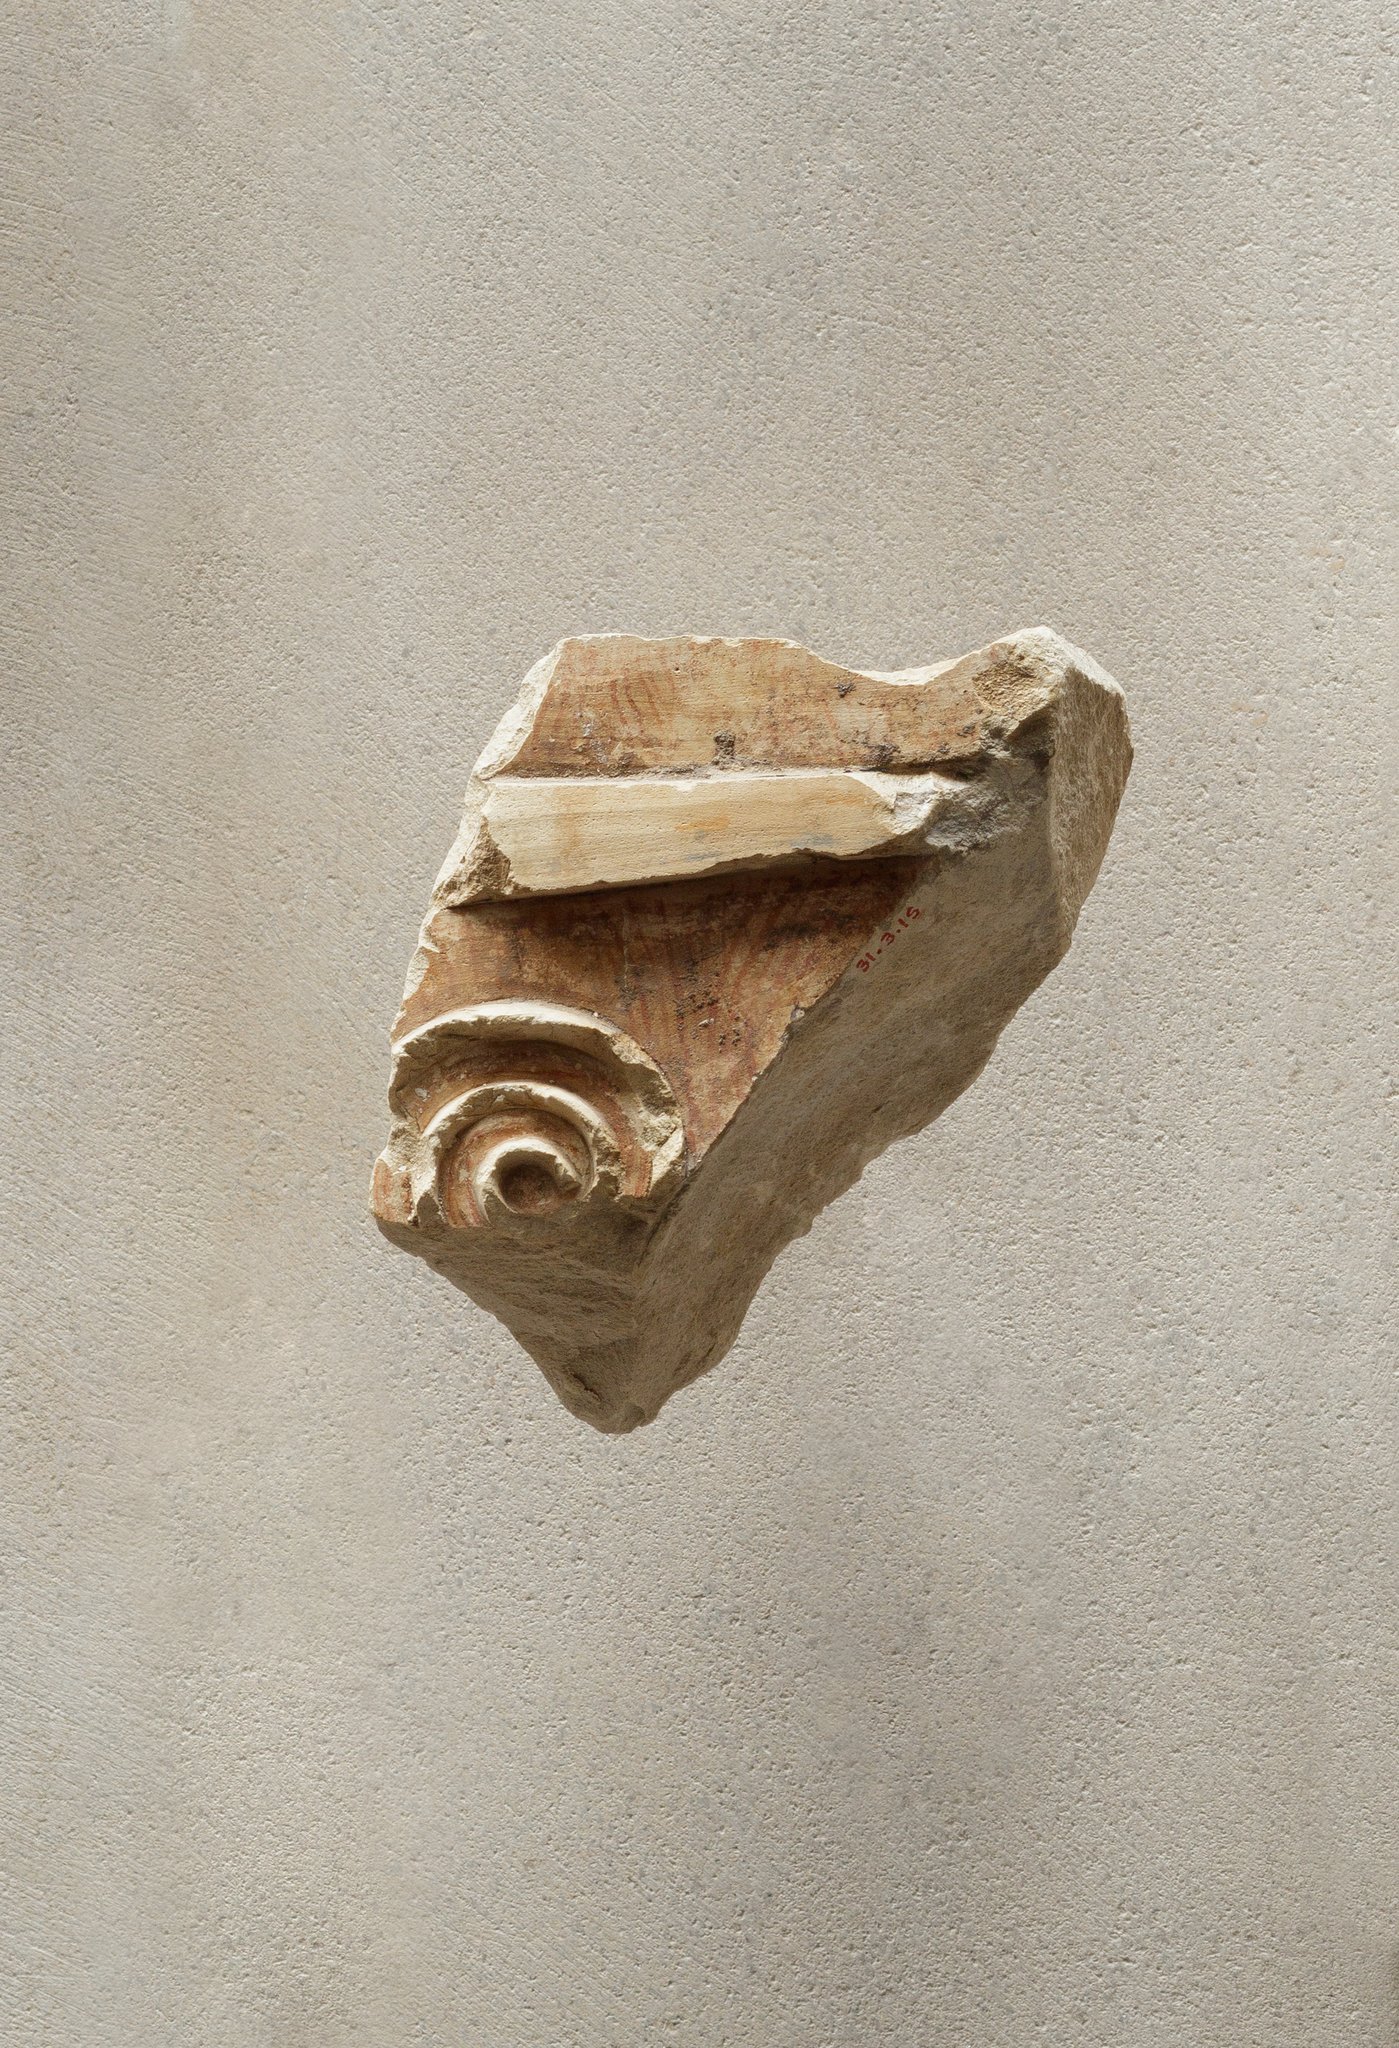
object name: relief, neferu, doorway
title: Relief fragment from elaborate doorway - see 26.3.353-5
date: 2051-2030 BCE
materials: limestone, paint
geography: egypt